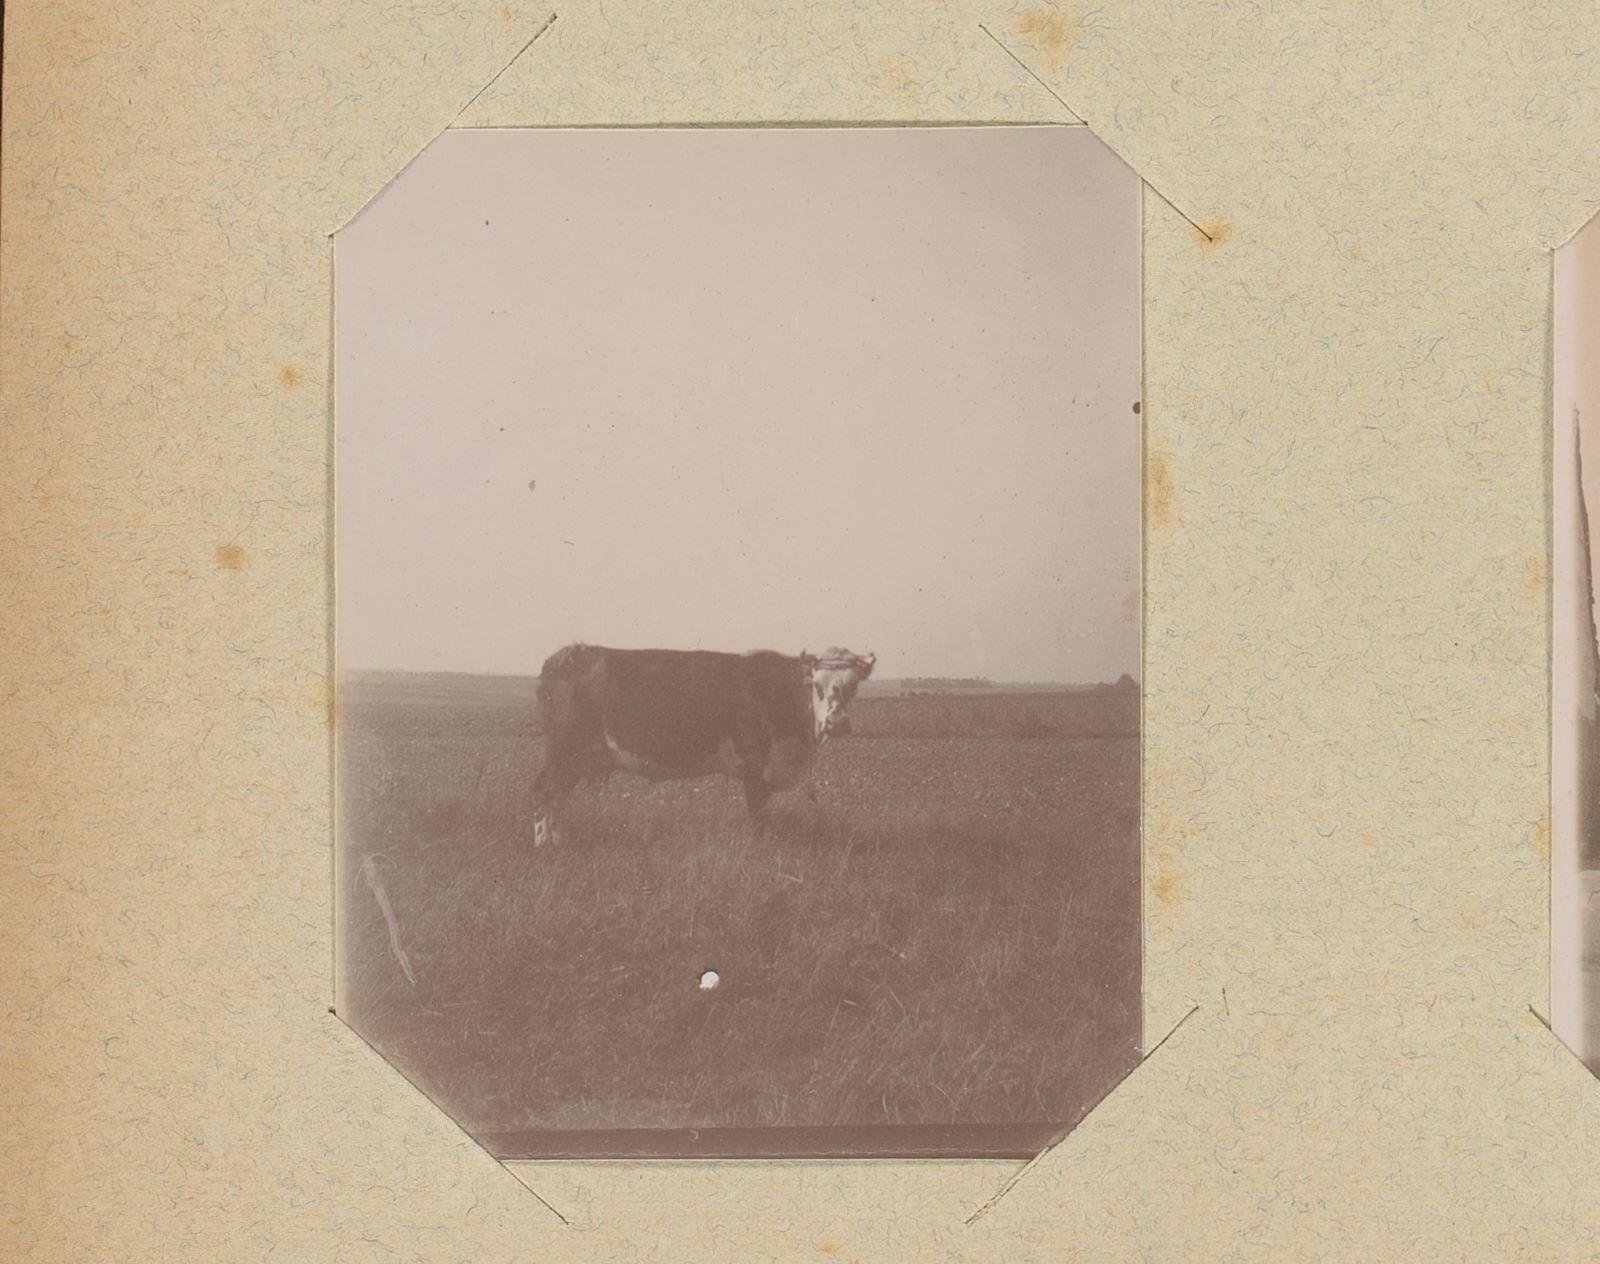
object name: album leaf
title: Koe in een veld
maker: Anonymous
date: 1895-1900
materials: paper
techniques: gelatin silver print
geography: france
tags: cow, france